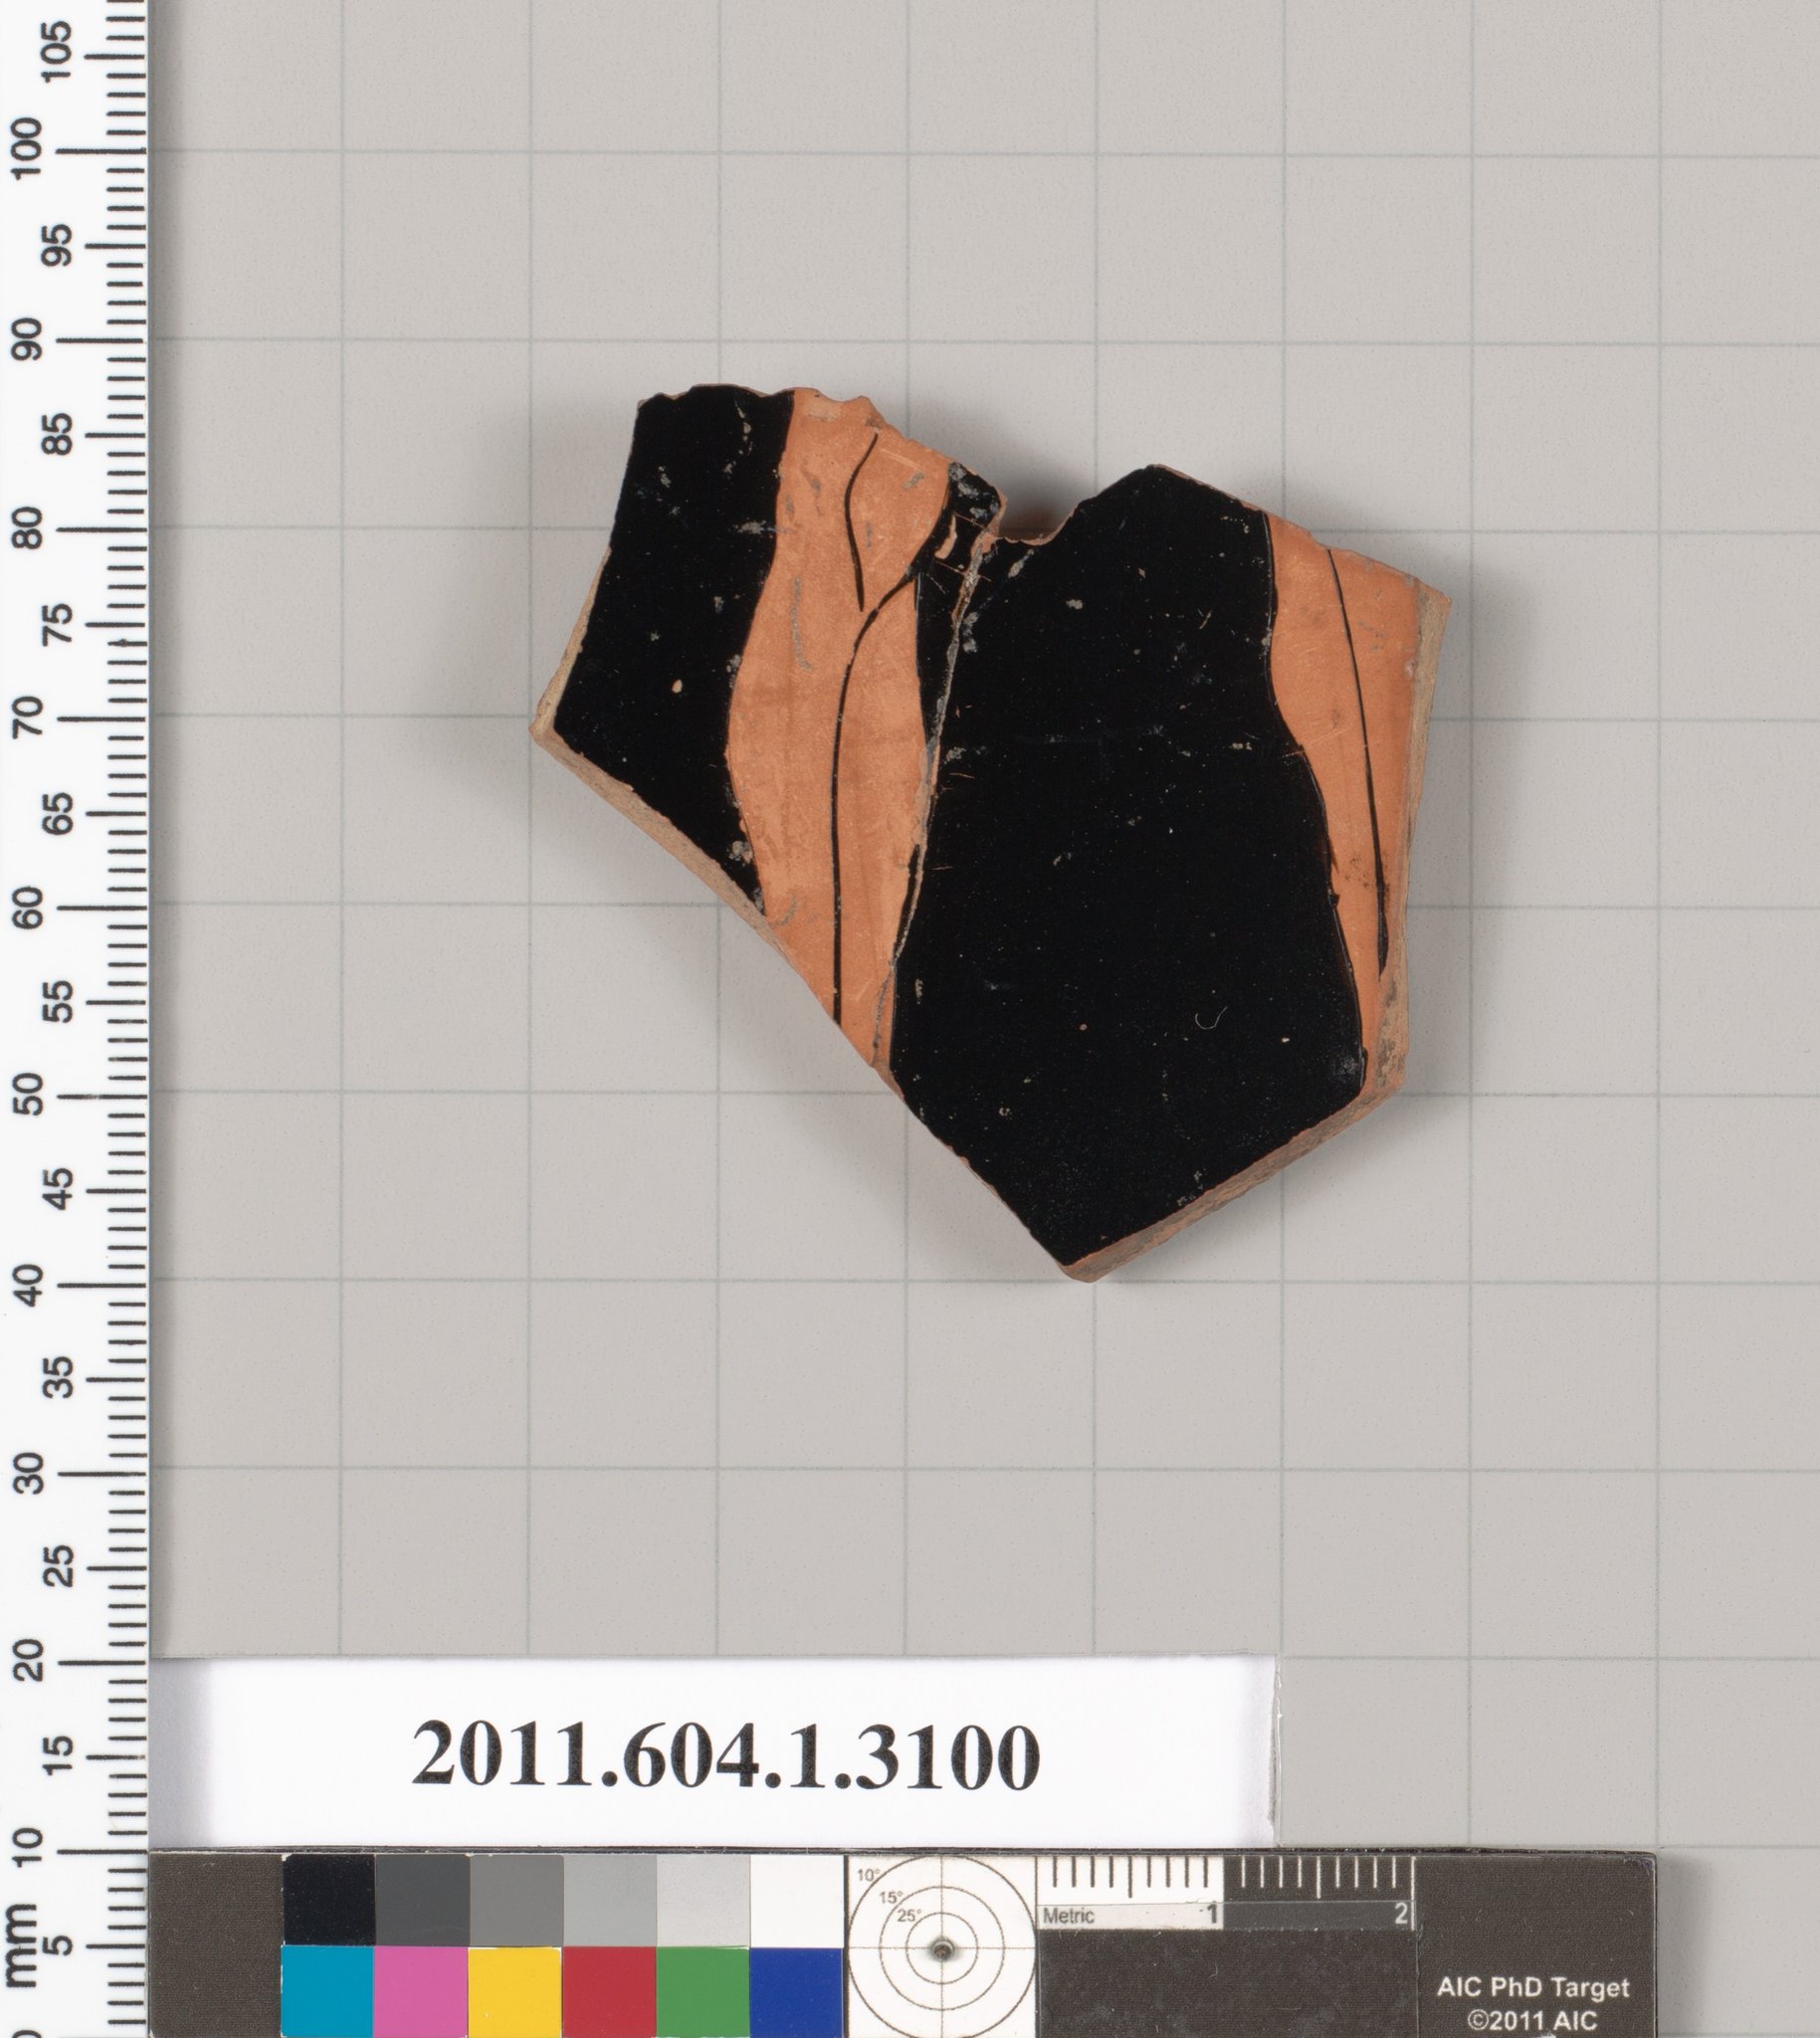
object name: kylix fragment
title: Terracotta fragment of a kylix (drinking cup)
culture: greek, attic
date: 500-480 BCE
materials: terracotta